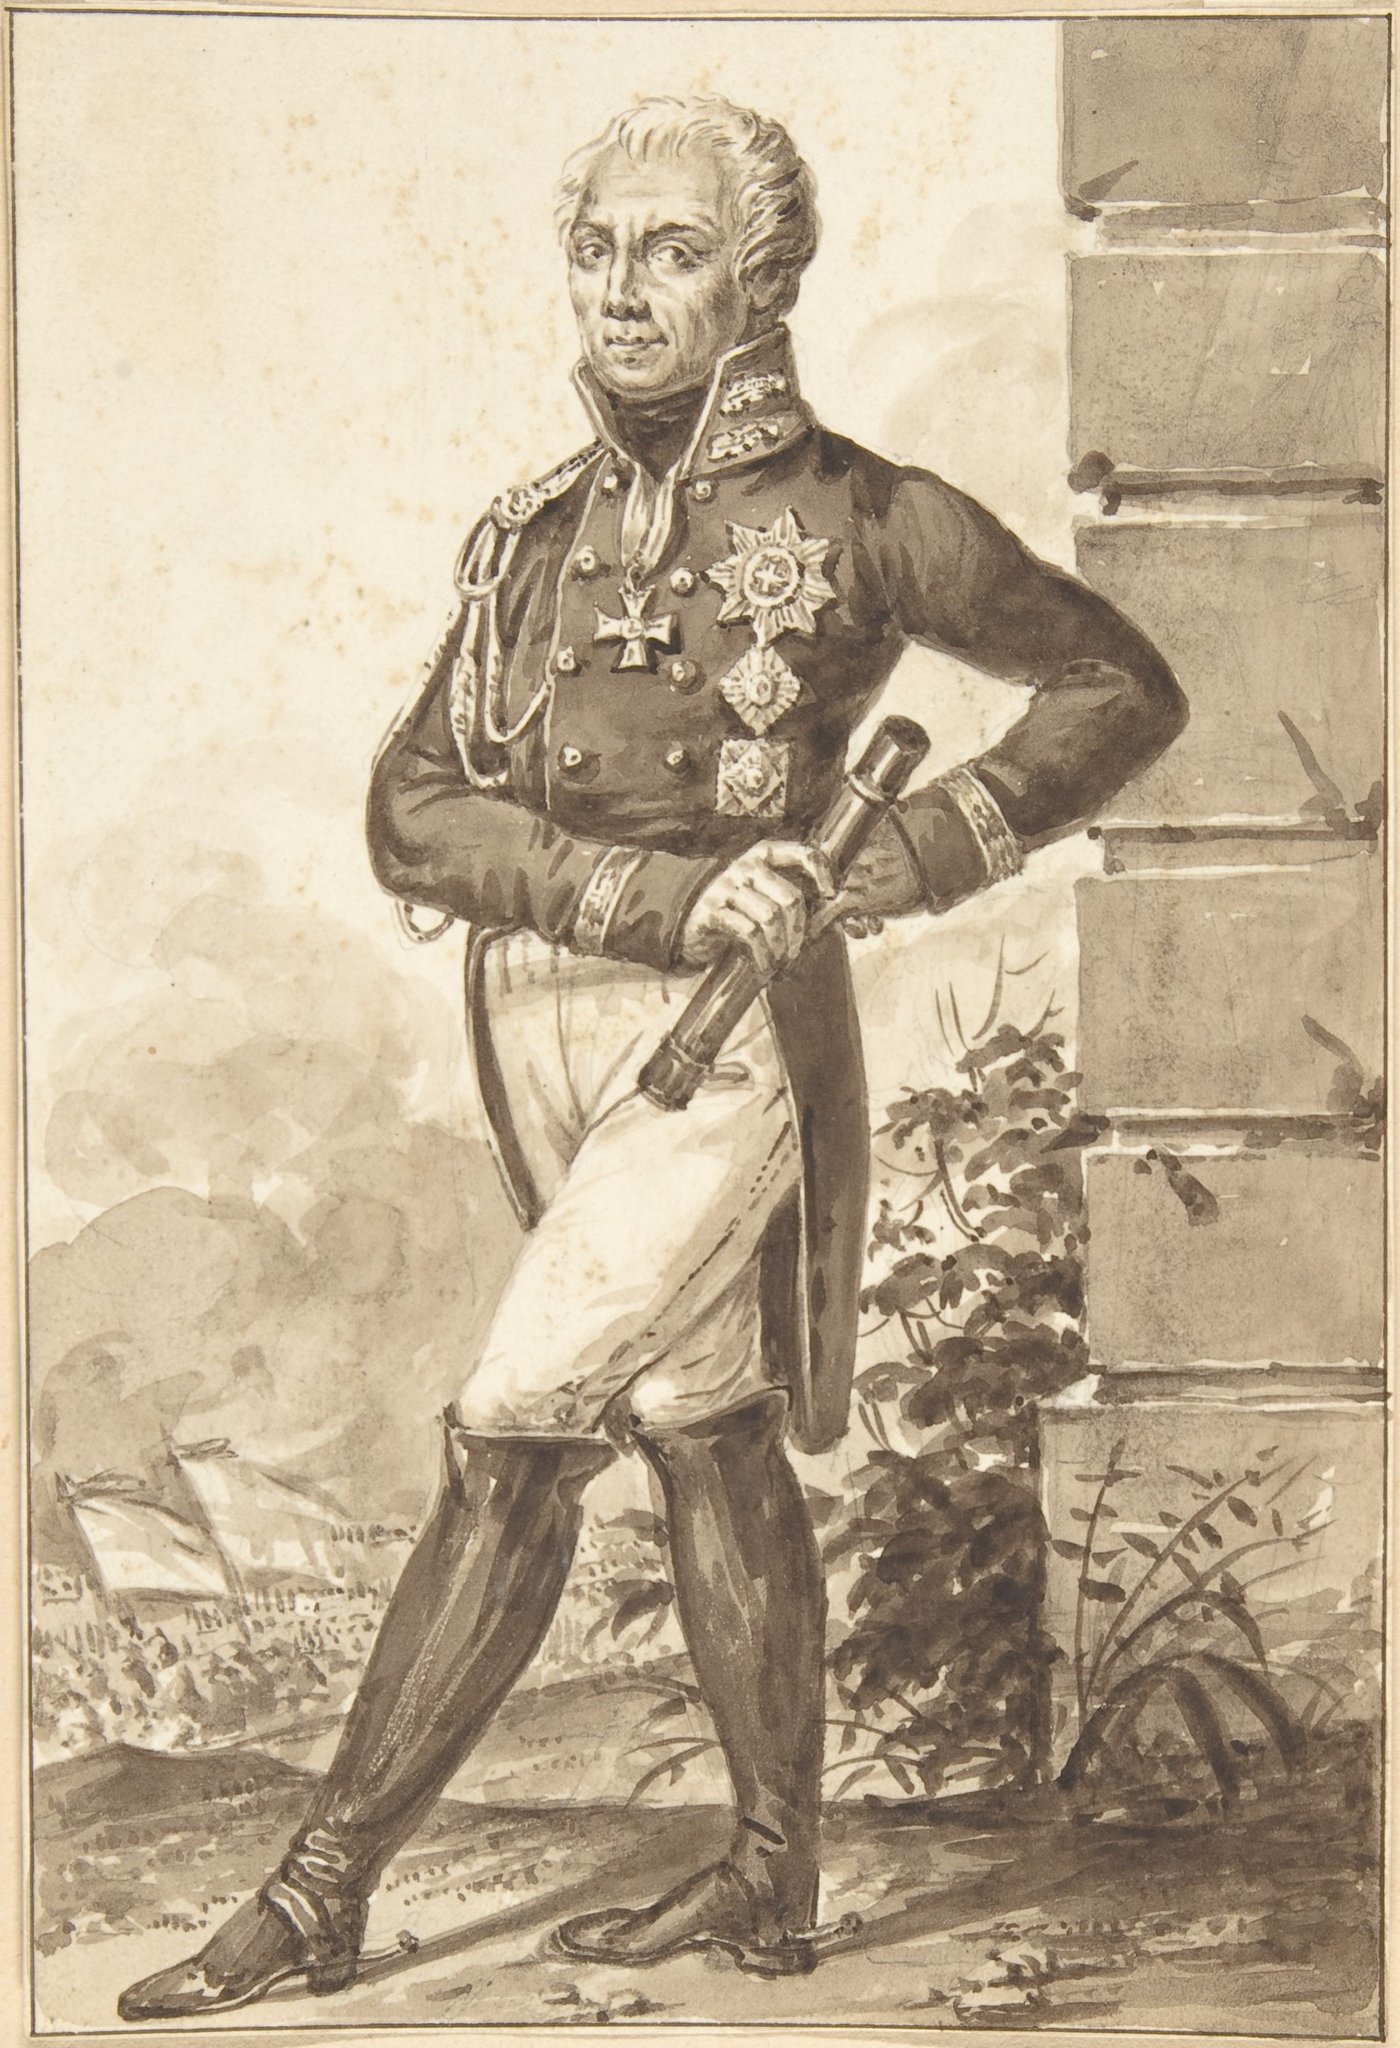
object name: drawing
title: Portrait of Count Levin August von Bennigsen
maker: jean-baptiste-françois bosio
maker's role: artist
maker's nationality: french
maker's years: 1764-1827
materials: graphite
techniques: brush, wash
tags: men,portraits